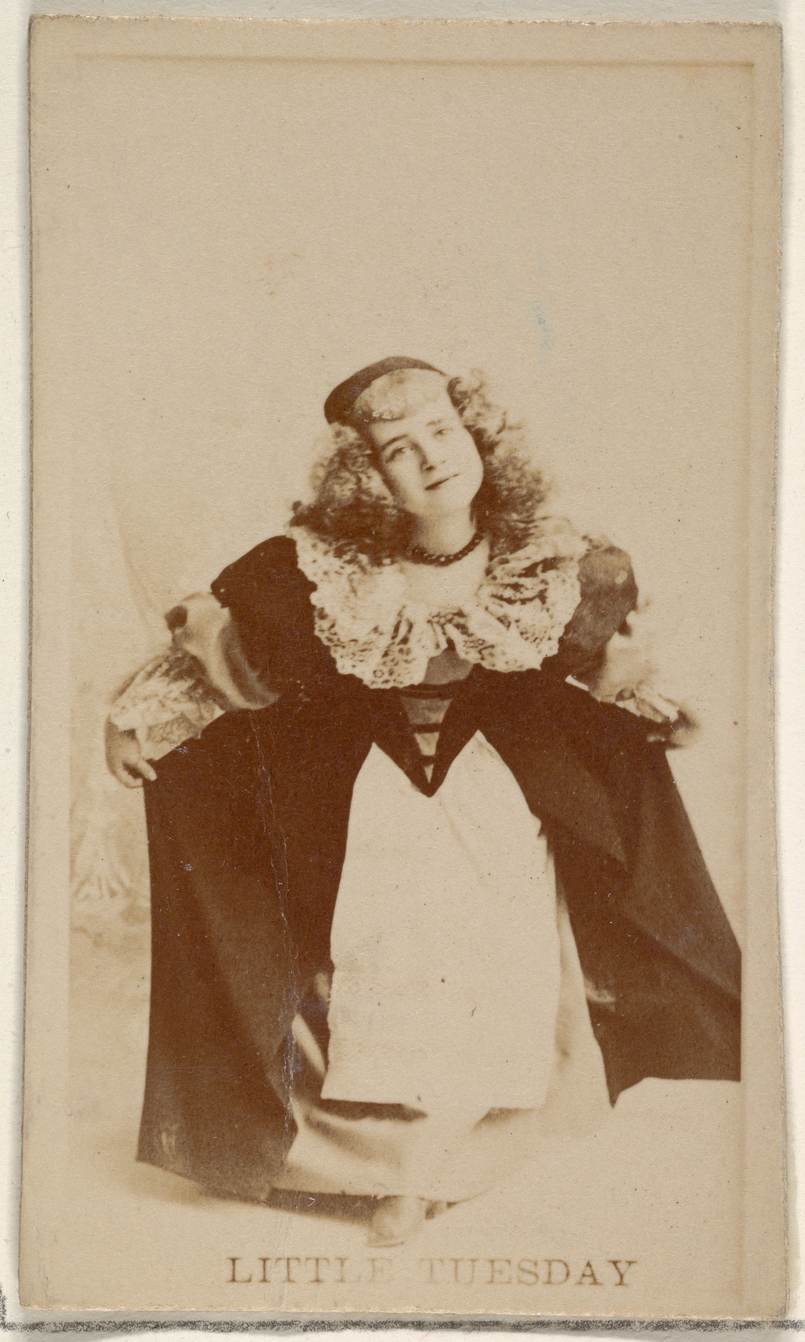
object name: photograph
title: Little Tuesday, from the Actors and Actresses series (N45, Type 8) for Virginia Brights Cigarettes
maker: allen & ginter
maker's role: publisher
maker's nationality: american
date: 1888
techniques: albumen silver print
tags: girls,portraits,actresses